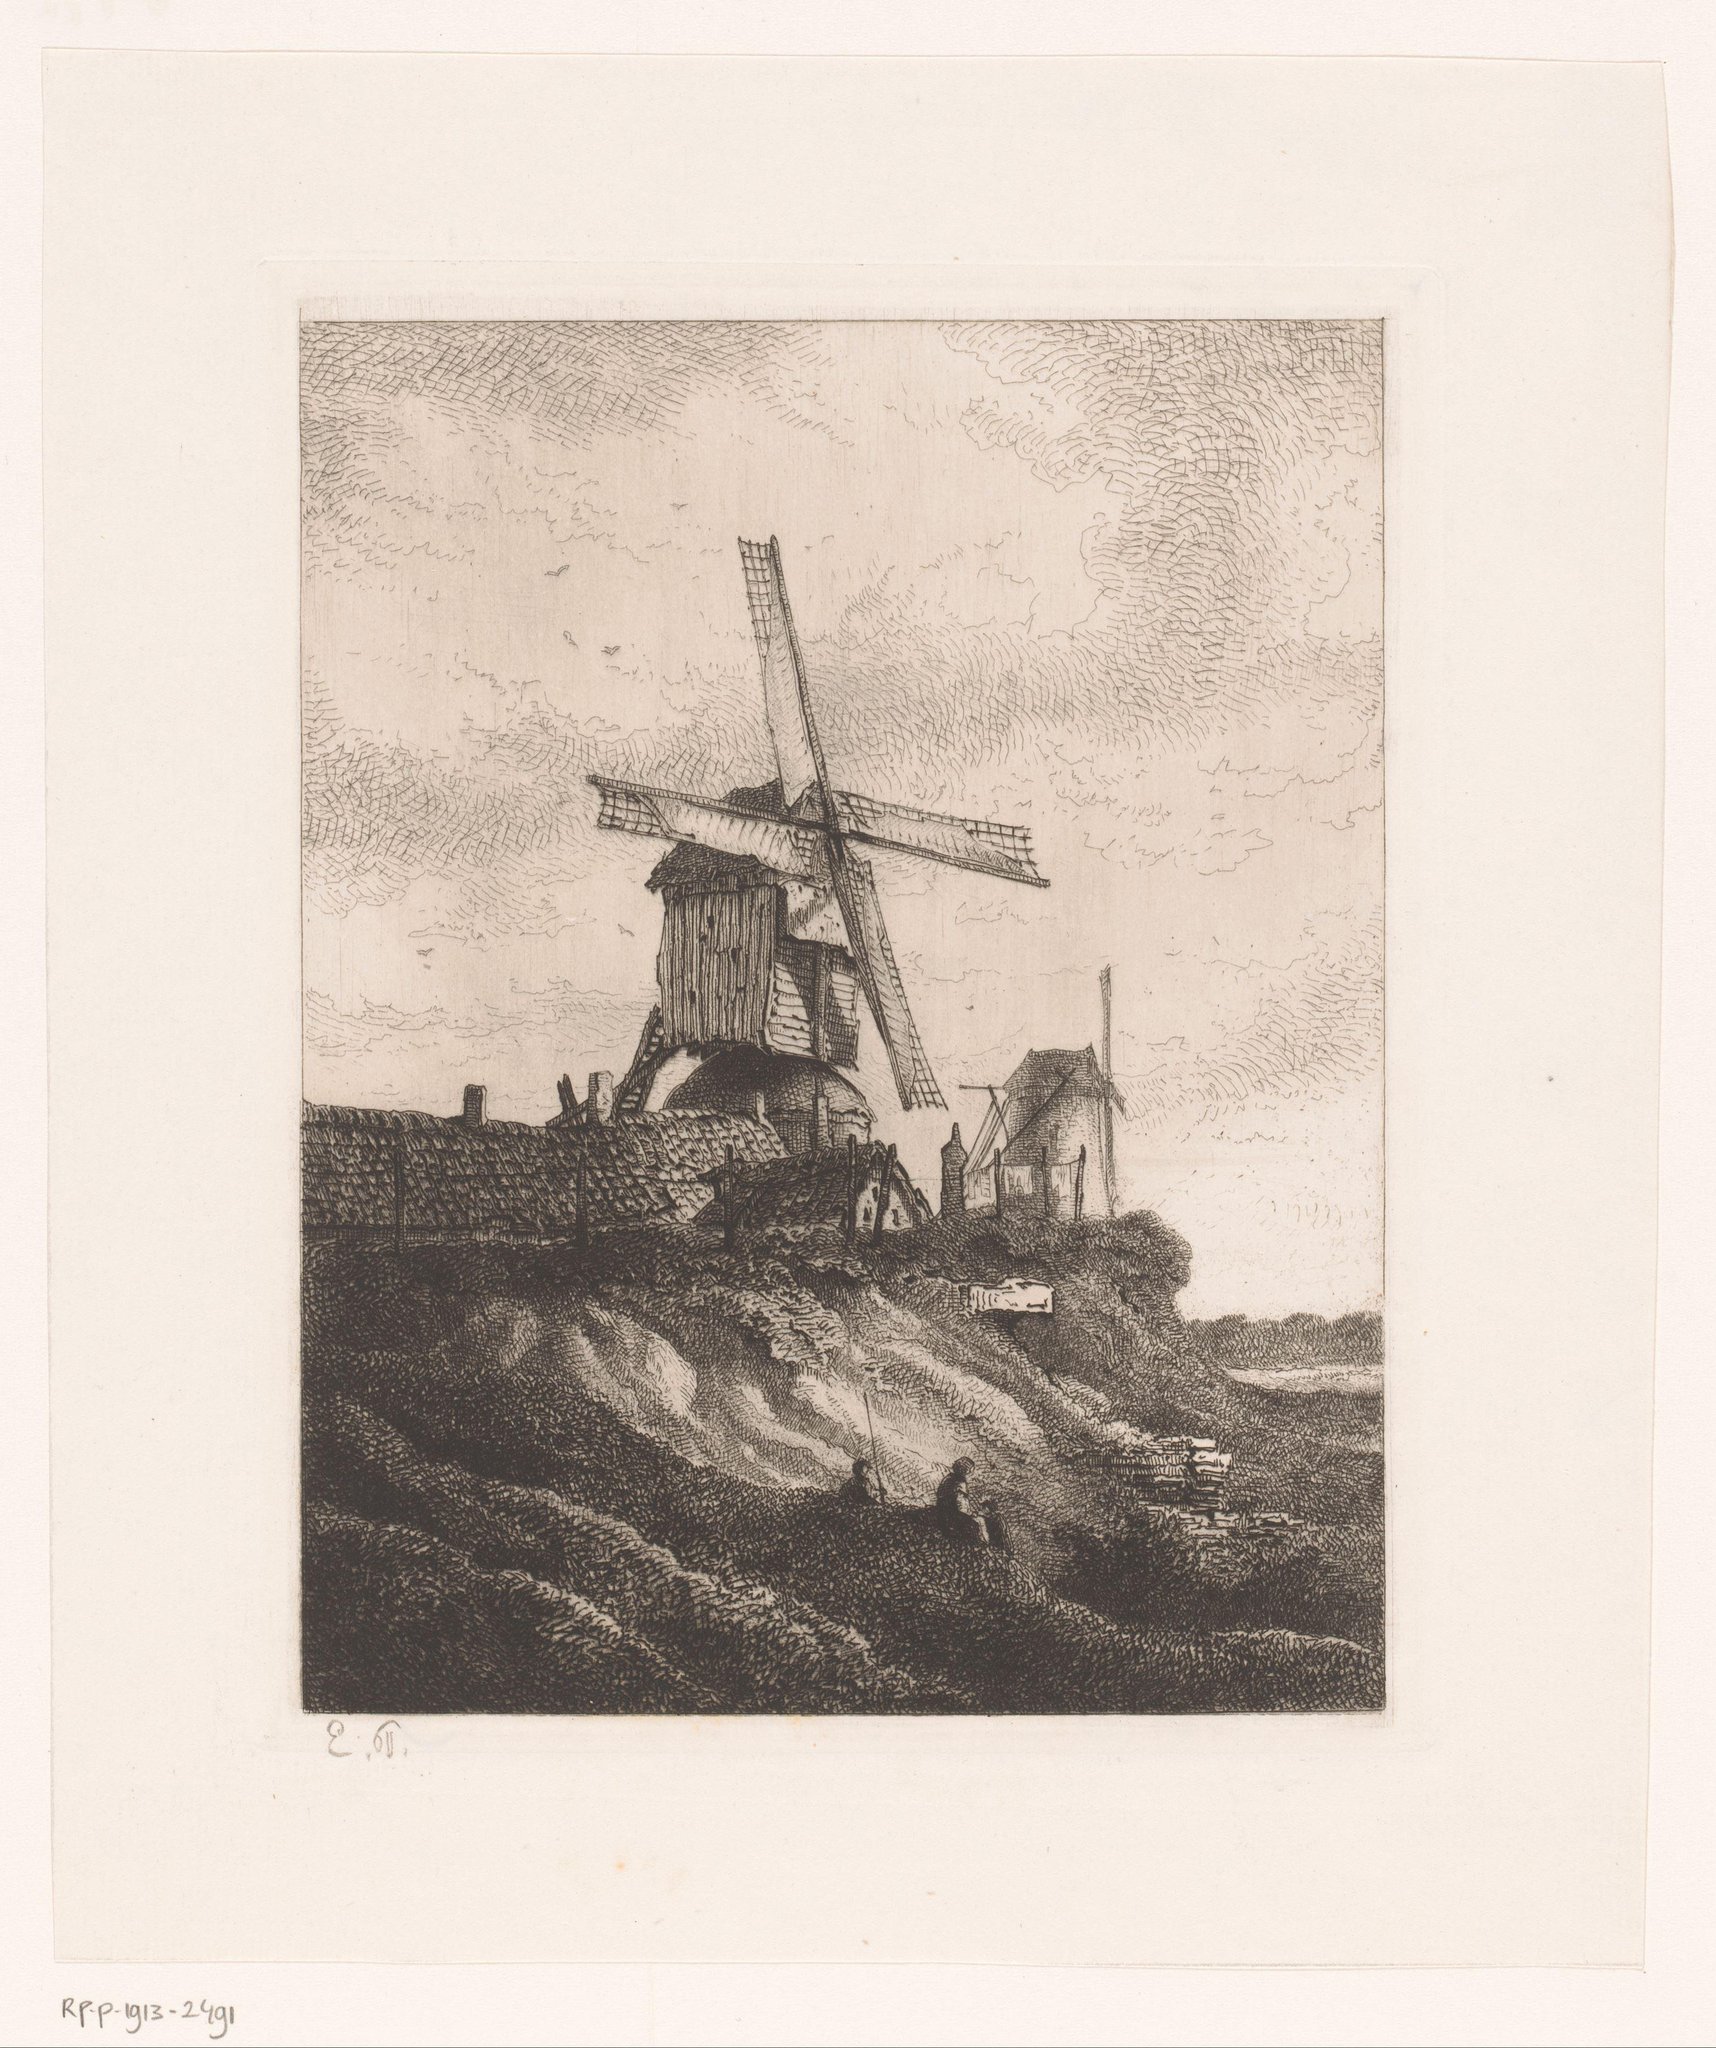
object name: print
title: Landschap met twee molens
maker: emile puttaert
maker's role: print maker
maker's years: 1829-1901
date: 1839-1901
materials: paper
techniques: drypoint, etching, intaglio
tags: (high) hill, windmill in landscape (+ city(-scape) with figures, staffage)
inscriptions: collector's mark: Lugt 2228